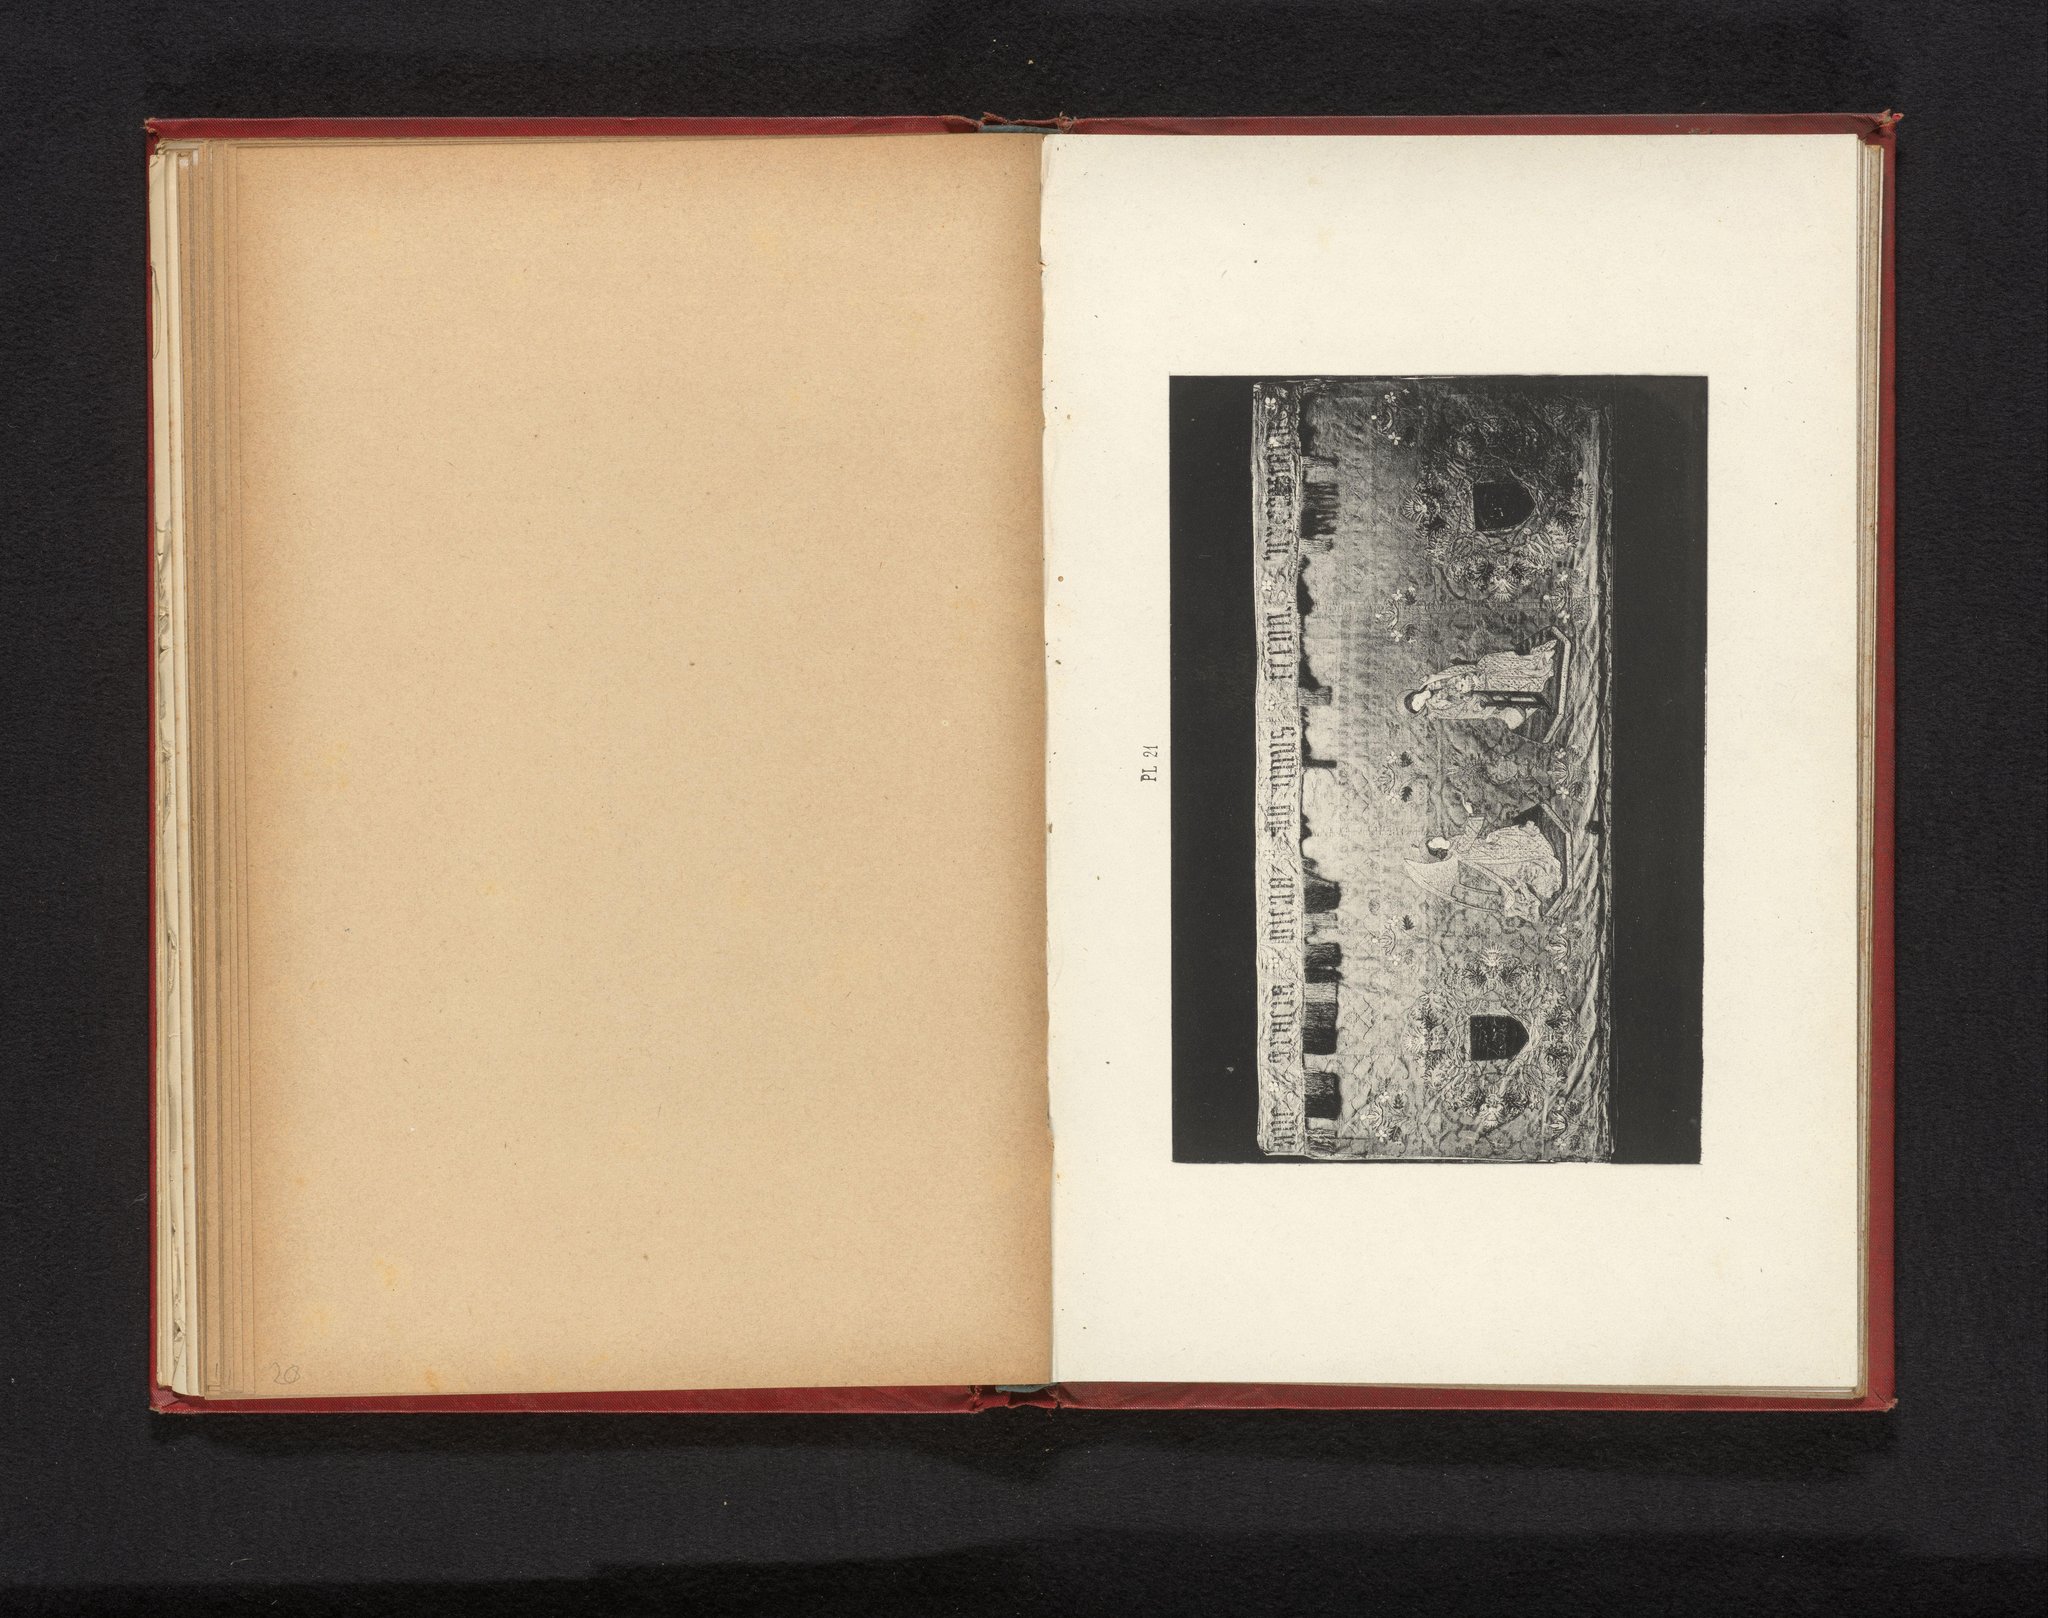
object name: photomechanical print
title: Tapijt met een afbeelding van de Annunciatie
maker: Anonymous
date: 1880-1881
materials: paper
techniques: photograph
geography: barcelona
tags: carpet, rug, the annunciation: mary sitting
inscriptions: number: ‘Pl 21’